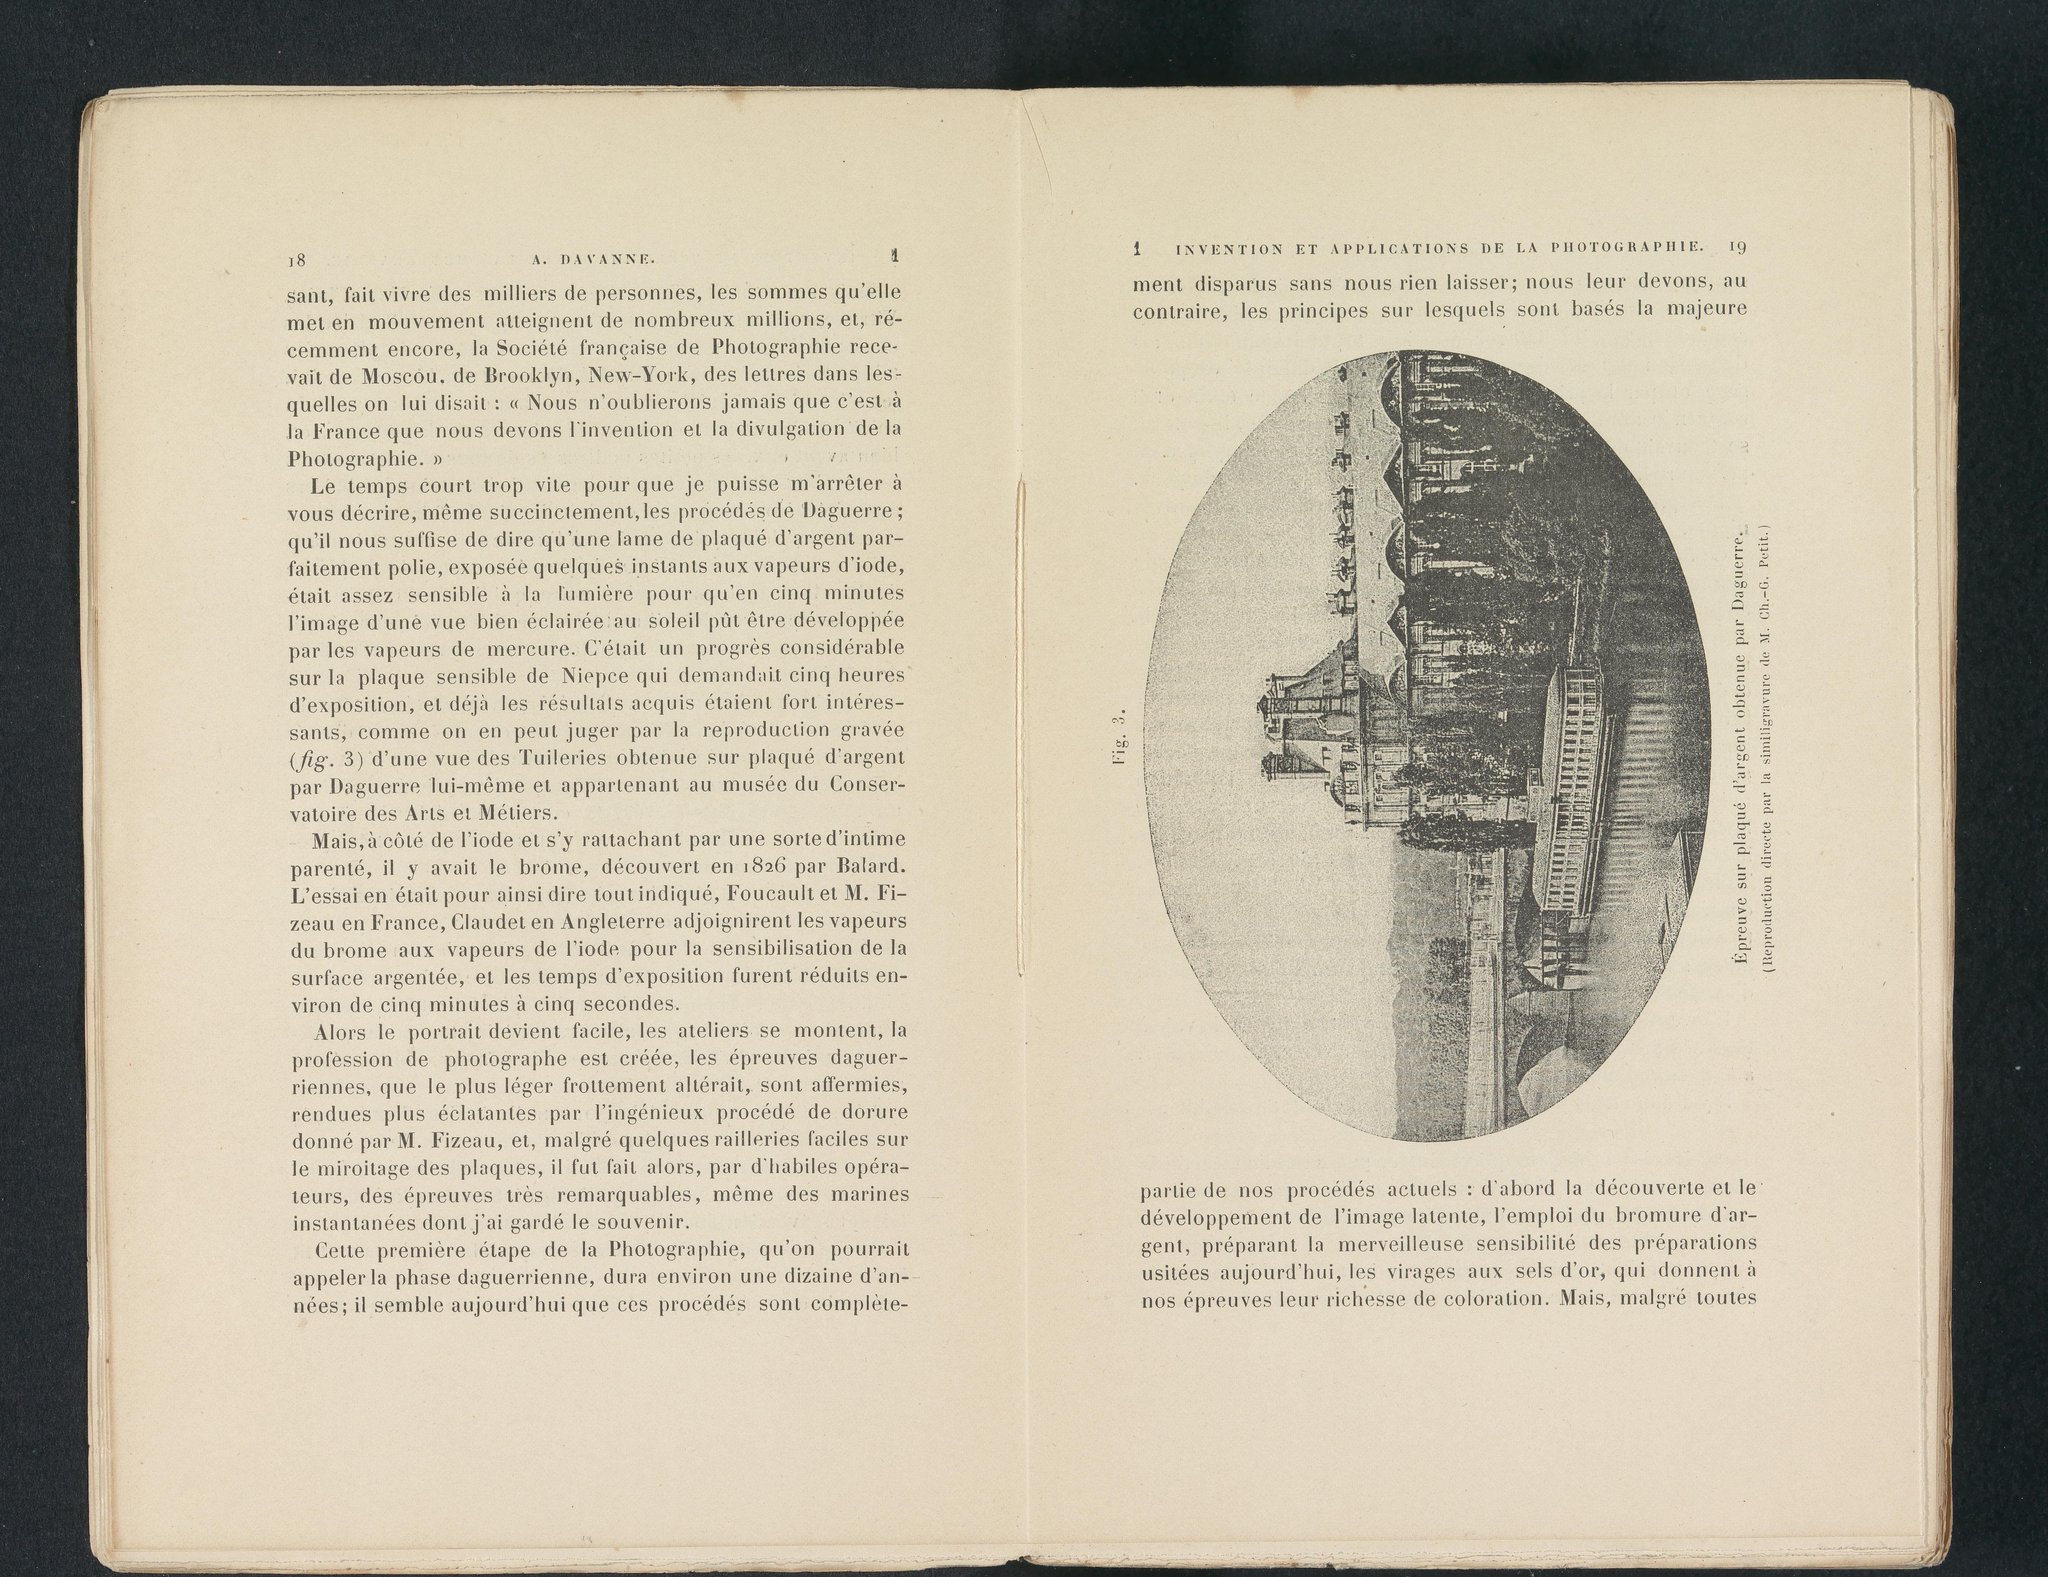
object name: photomechanical print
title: Reproductie van een foto van een gezicht op het Palais des Tuileries te Parijs door Daguerre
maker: louis jacques mandé daguerre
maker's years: 1787-1851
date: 1893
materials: paper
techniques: autotype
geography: paris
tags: palace, façade (of house or building), tuileries palace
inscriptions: number: ‘Fig. 3.’, inscription: ‘Épreuve sur plaqué d'argent obtenue par Daguerre.’